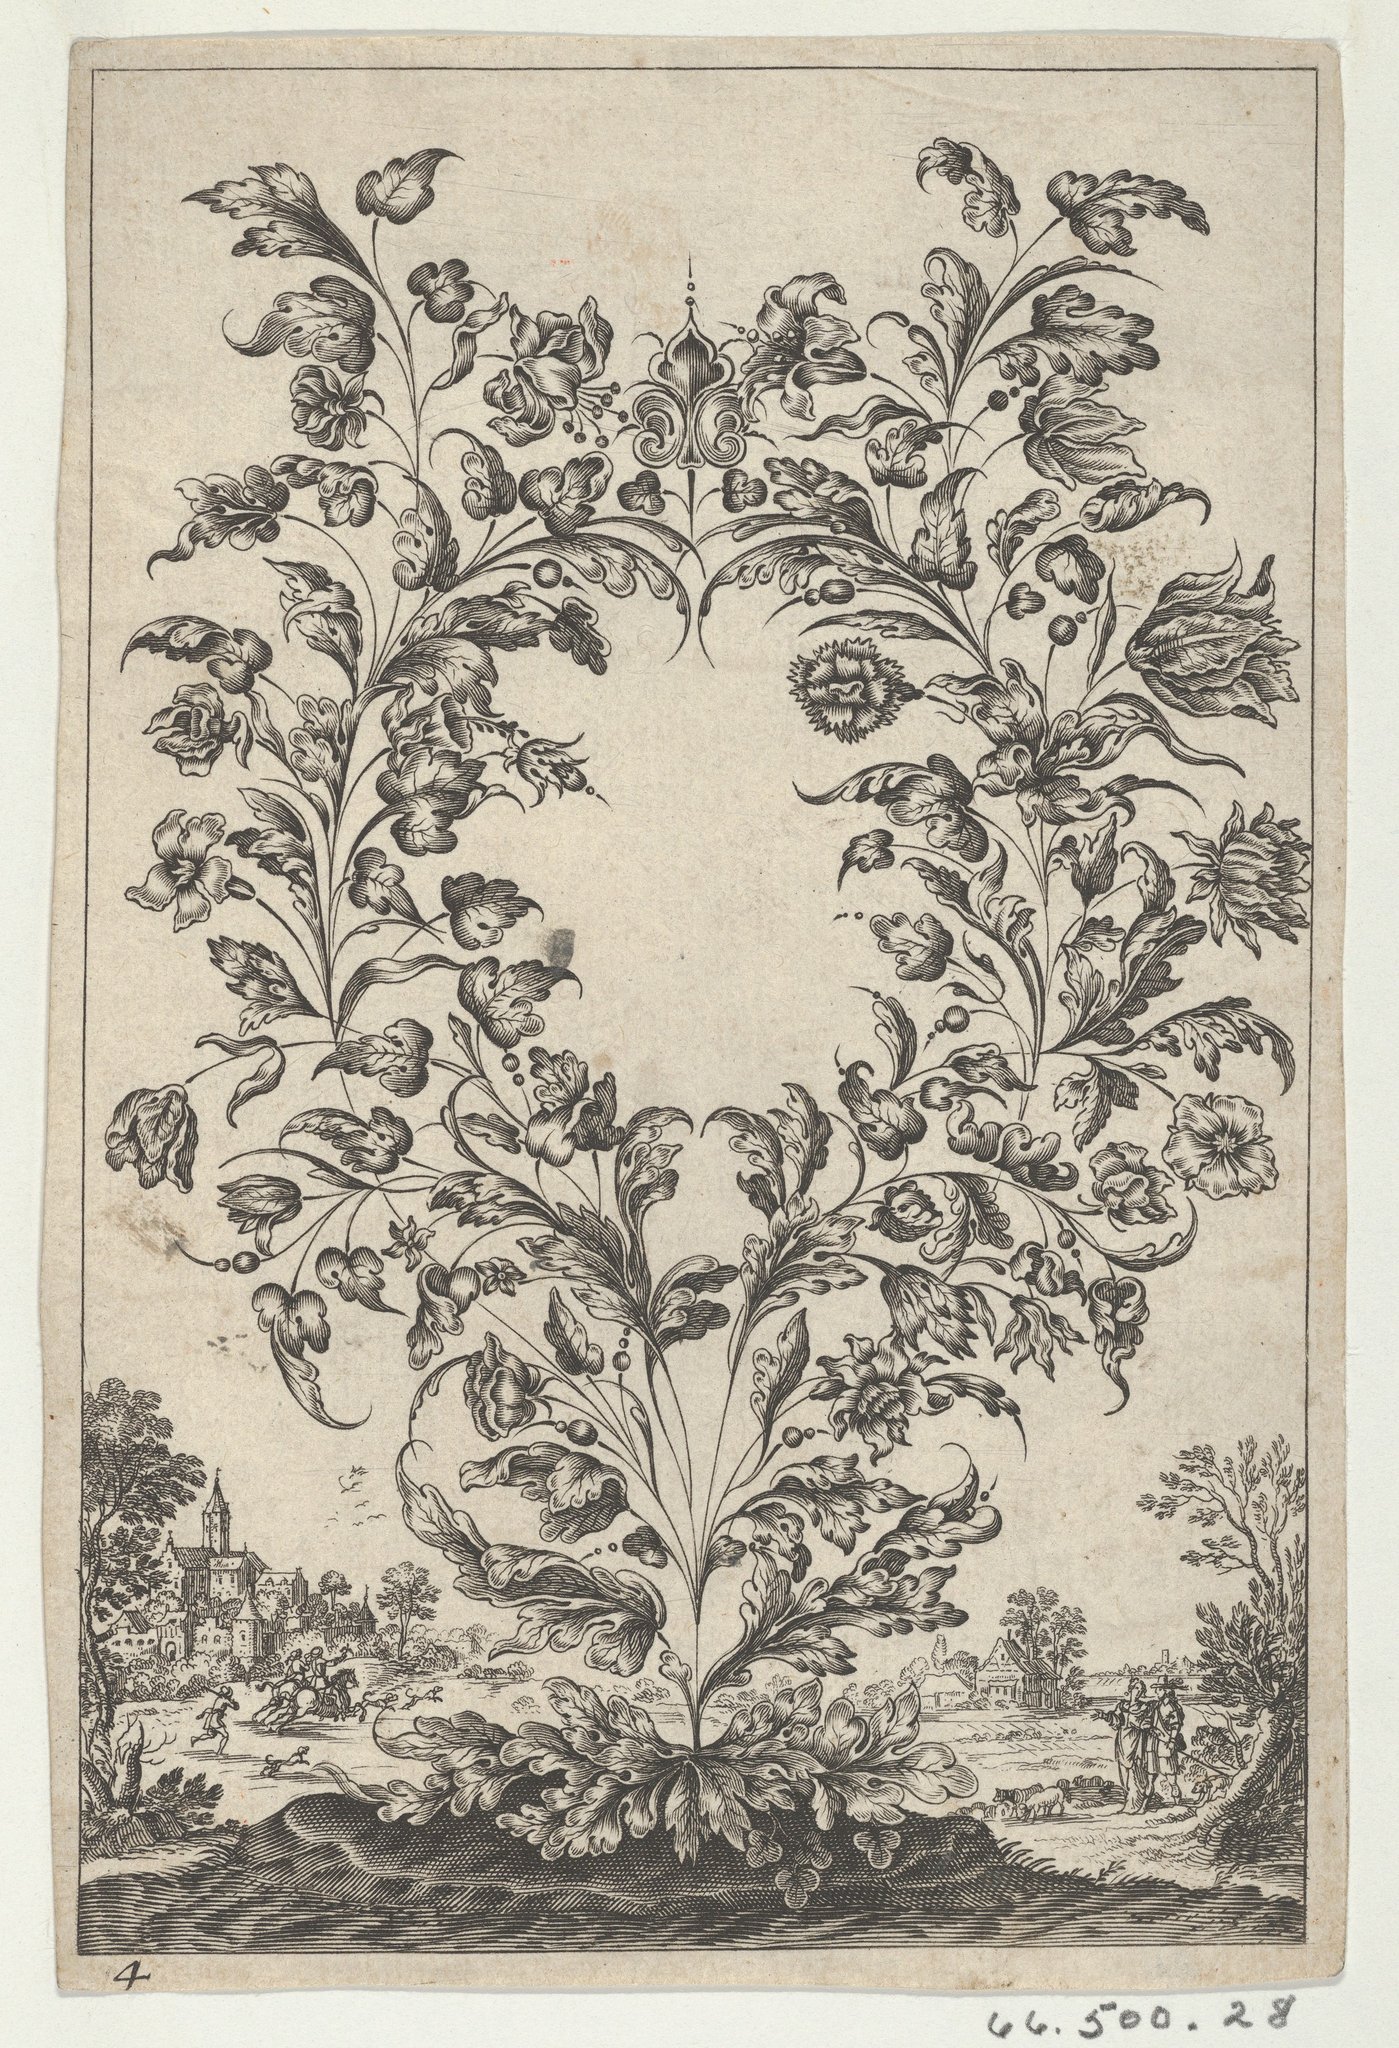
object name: print ornament architecture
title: Ornament with Jewelry Design as Decorative Floral Arrangement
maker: anonymous, 17th century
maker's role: artist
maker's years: 1600-1700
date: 1601-1700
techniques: engraving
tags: flowers,leaves